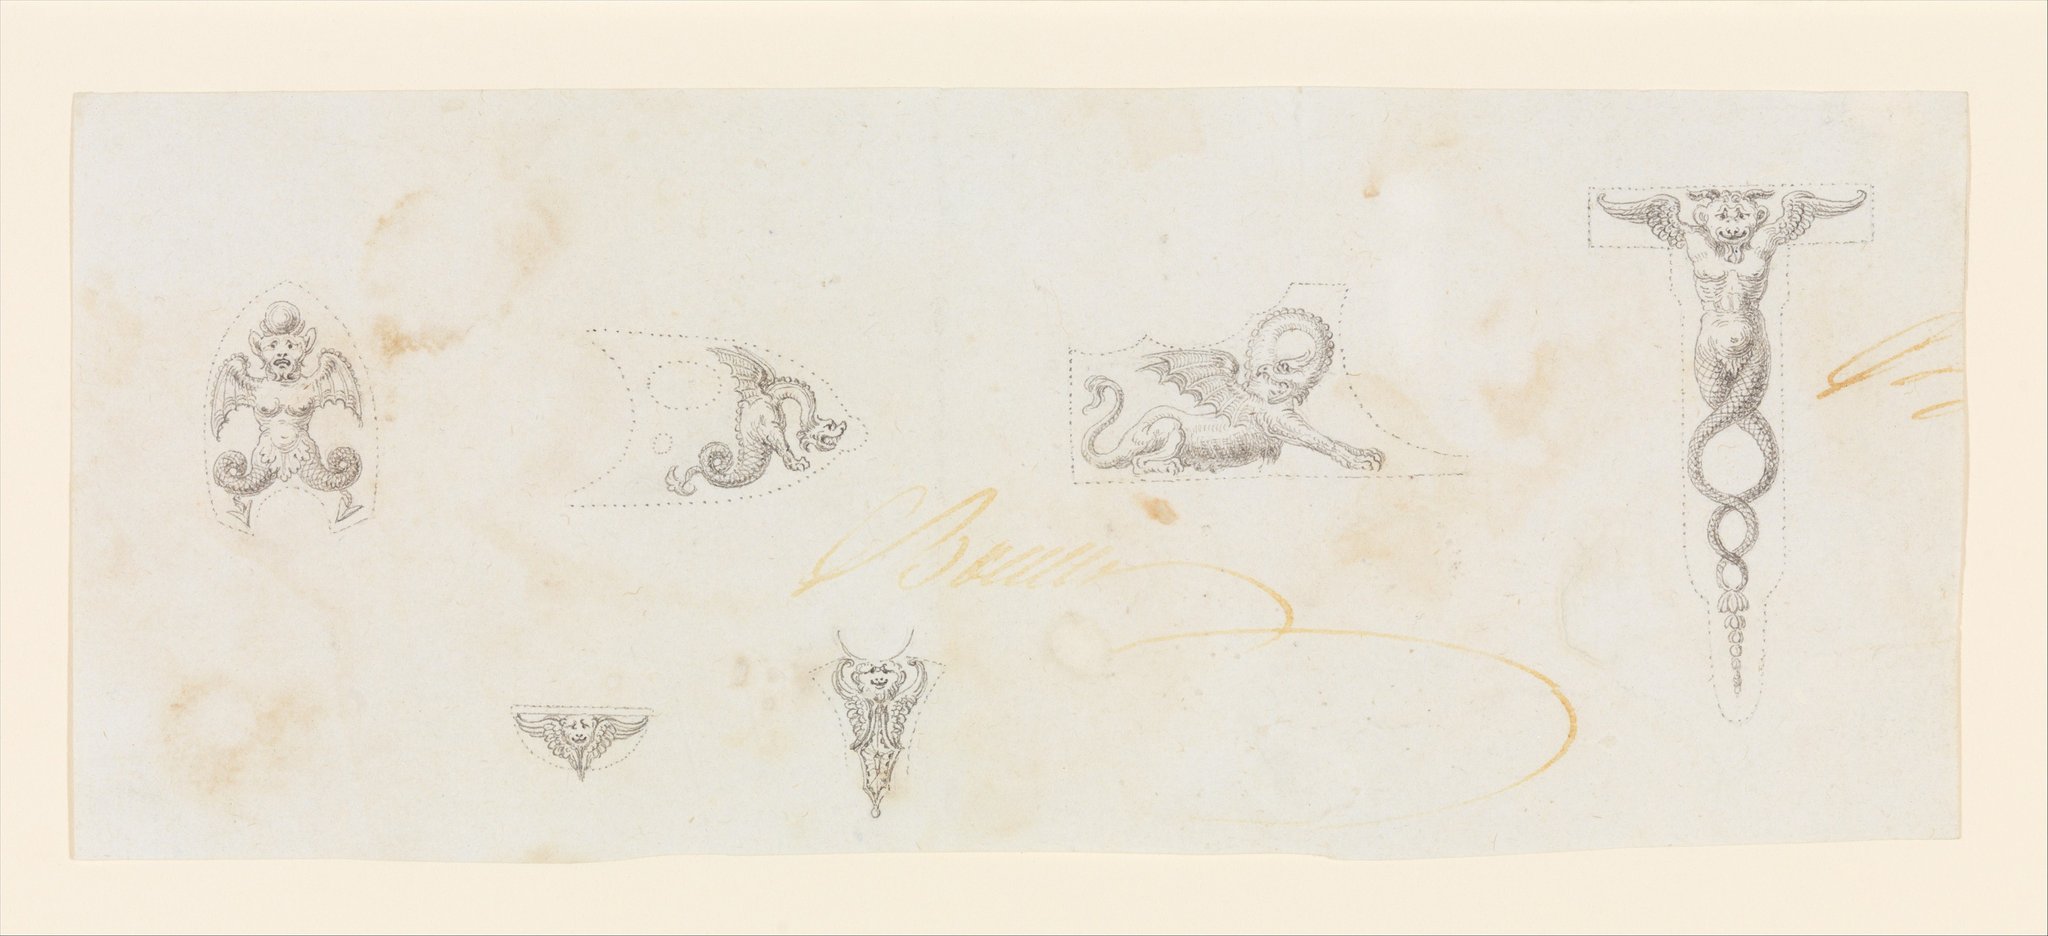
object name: drawing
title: Designs for the Decoration of Firearms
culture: french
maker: nicolas noël boutet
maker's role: designer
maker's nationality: french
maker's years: 1761-1833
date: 1797-1805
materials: ink, paper, pencil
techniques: wash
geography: france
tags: ornament